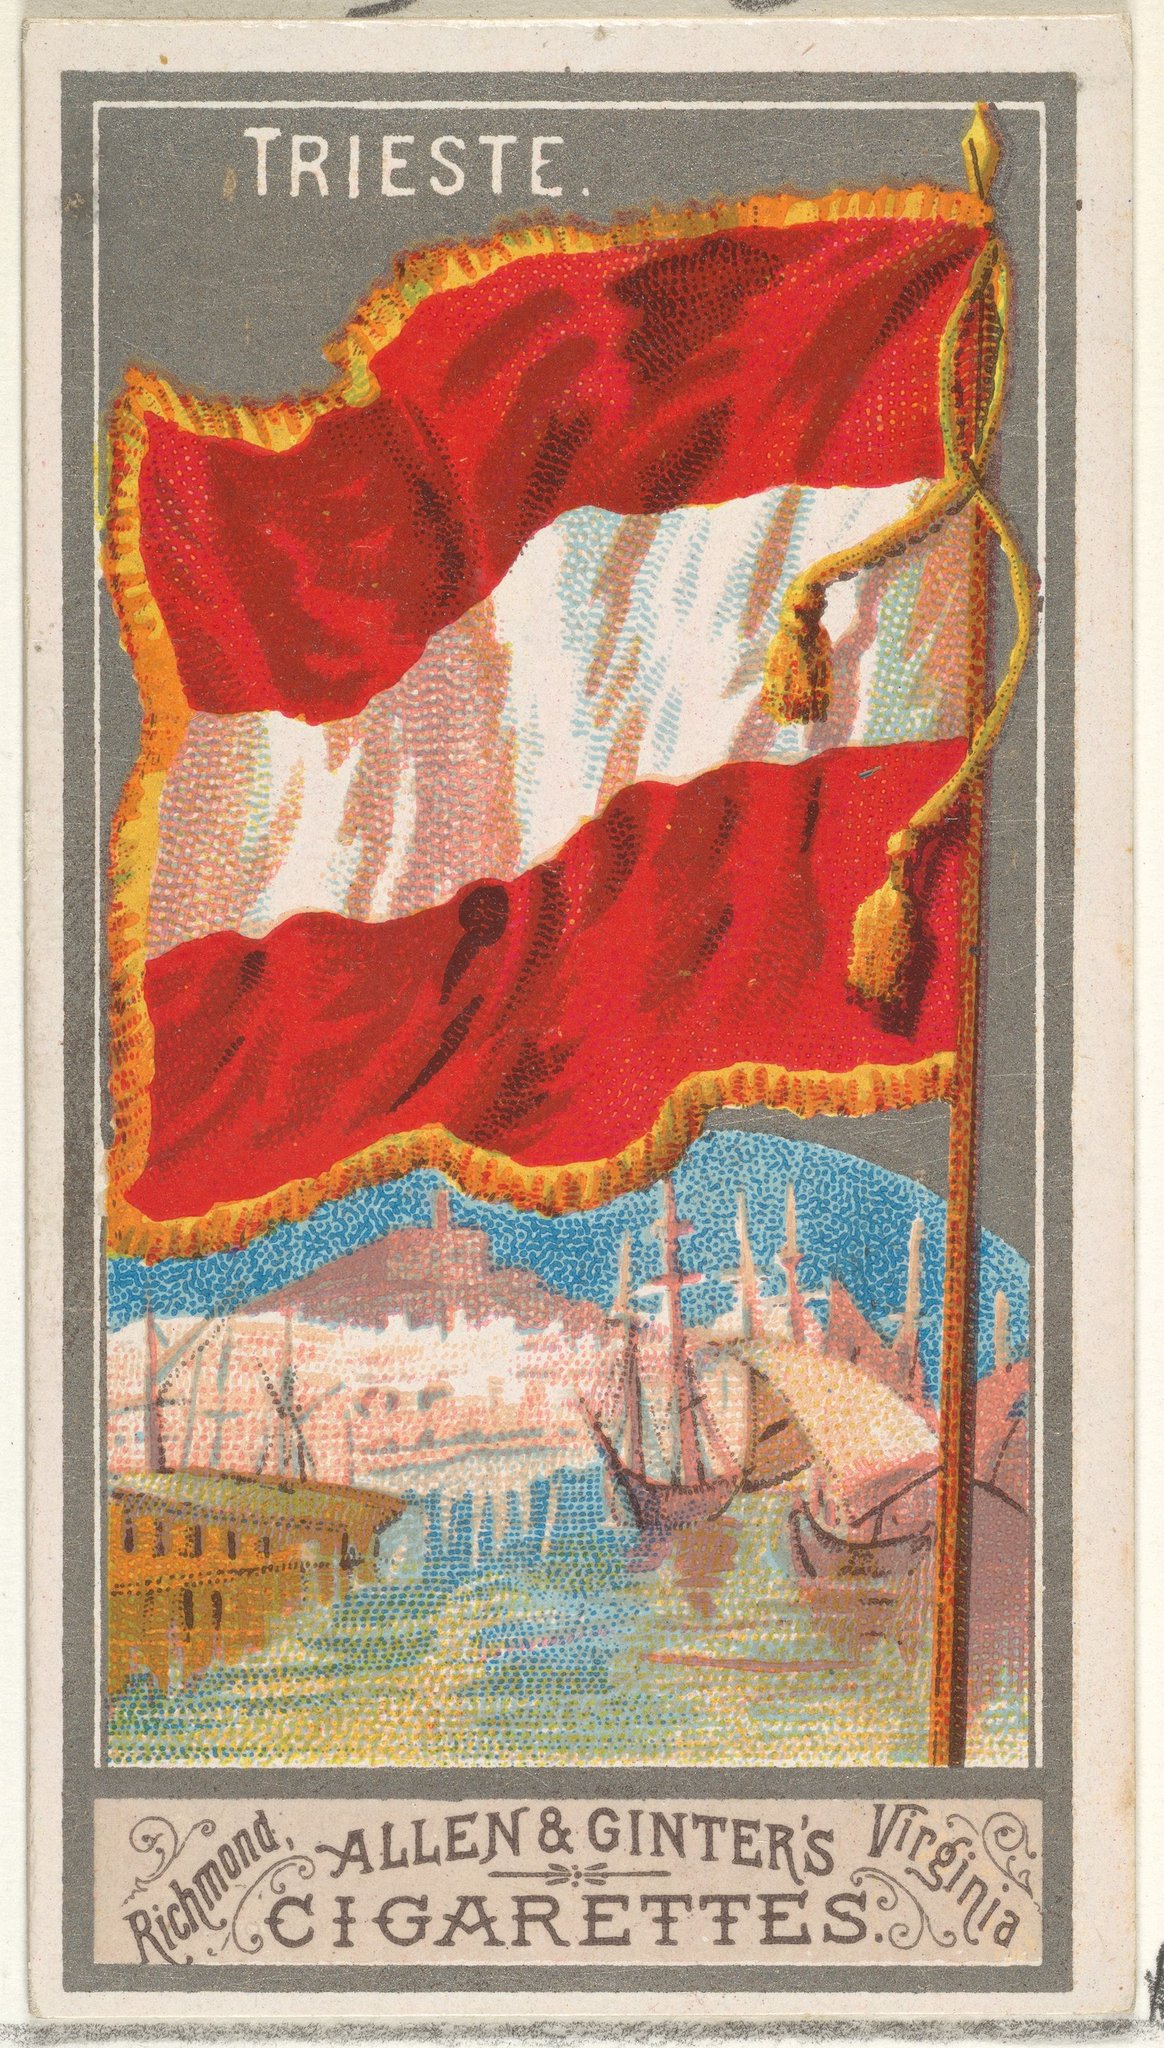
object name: print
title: Trieste, from the City Flags series (N6) for Allen & Ginter Cigarettes Brands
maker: allen & ginter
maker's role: publisher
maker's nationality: american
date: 1887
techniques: color lithograph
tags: flags